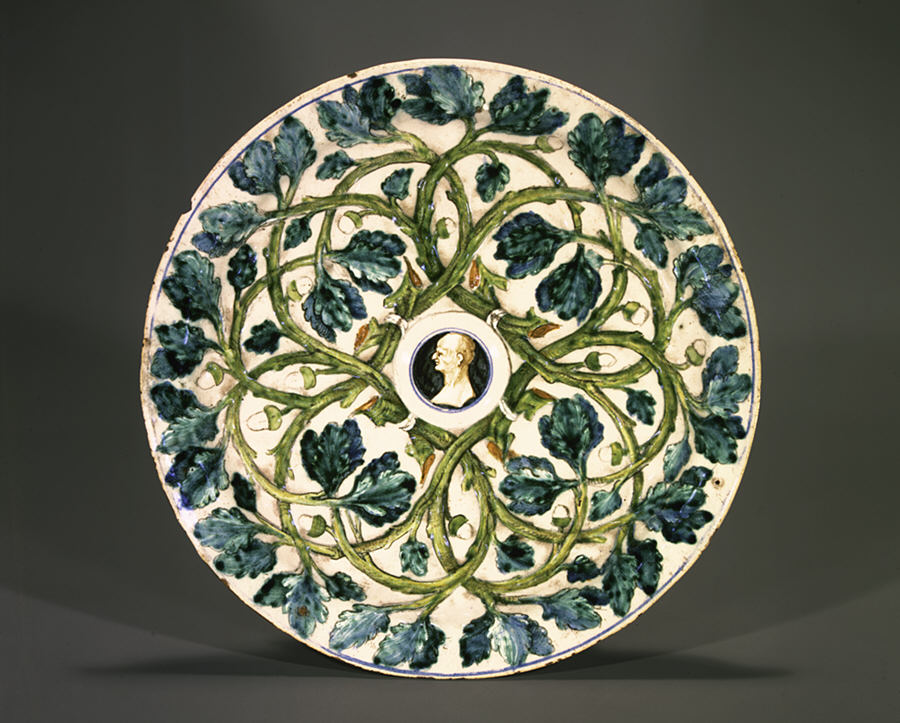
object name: dish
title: Dish (piatto)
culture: italian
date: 1525-1530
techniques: maiolica, glazing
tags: men,profiles,leaves